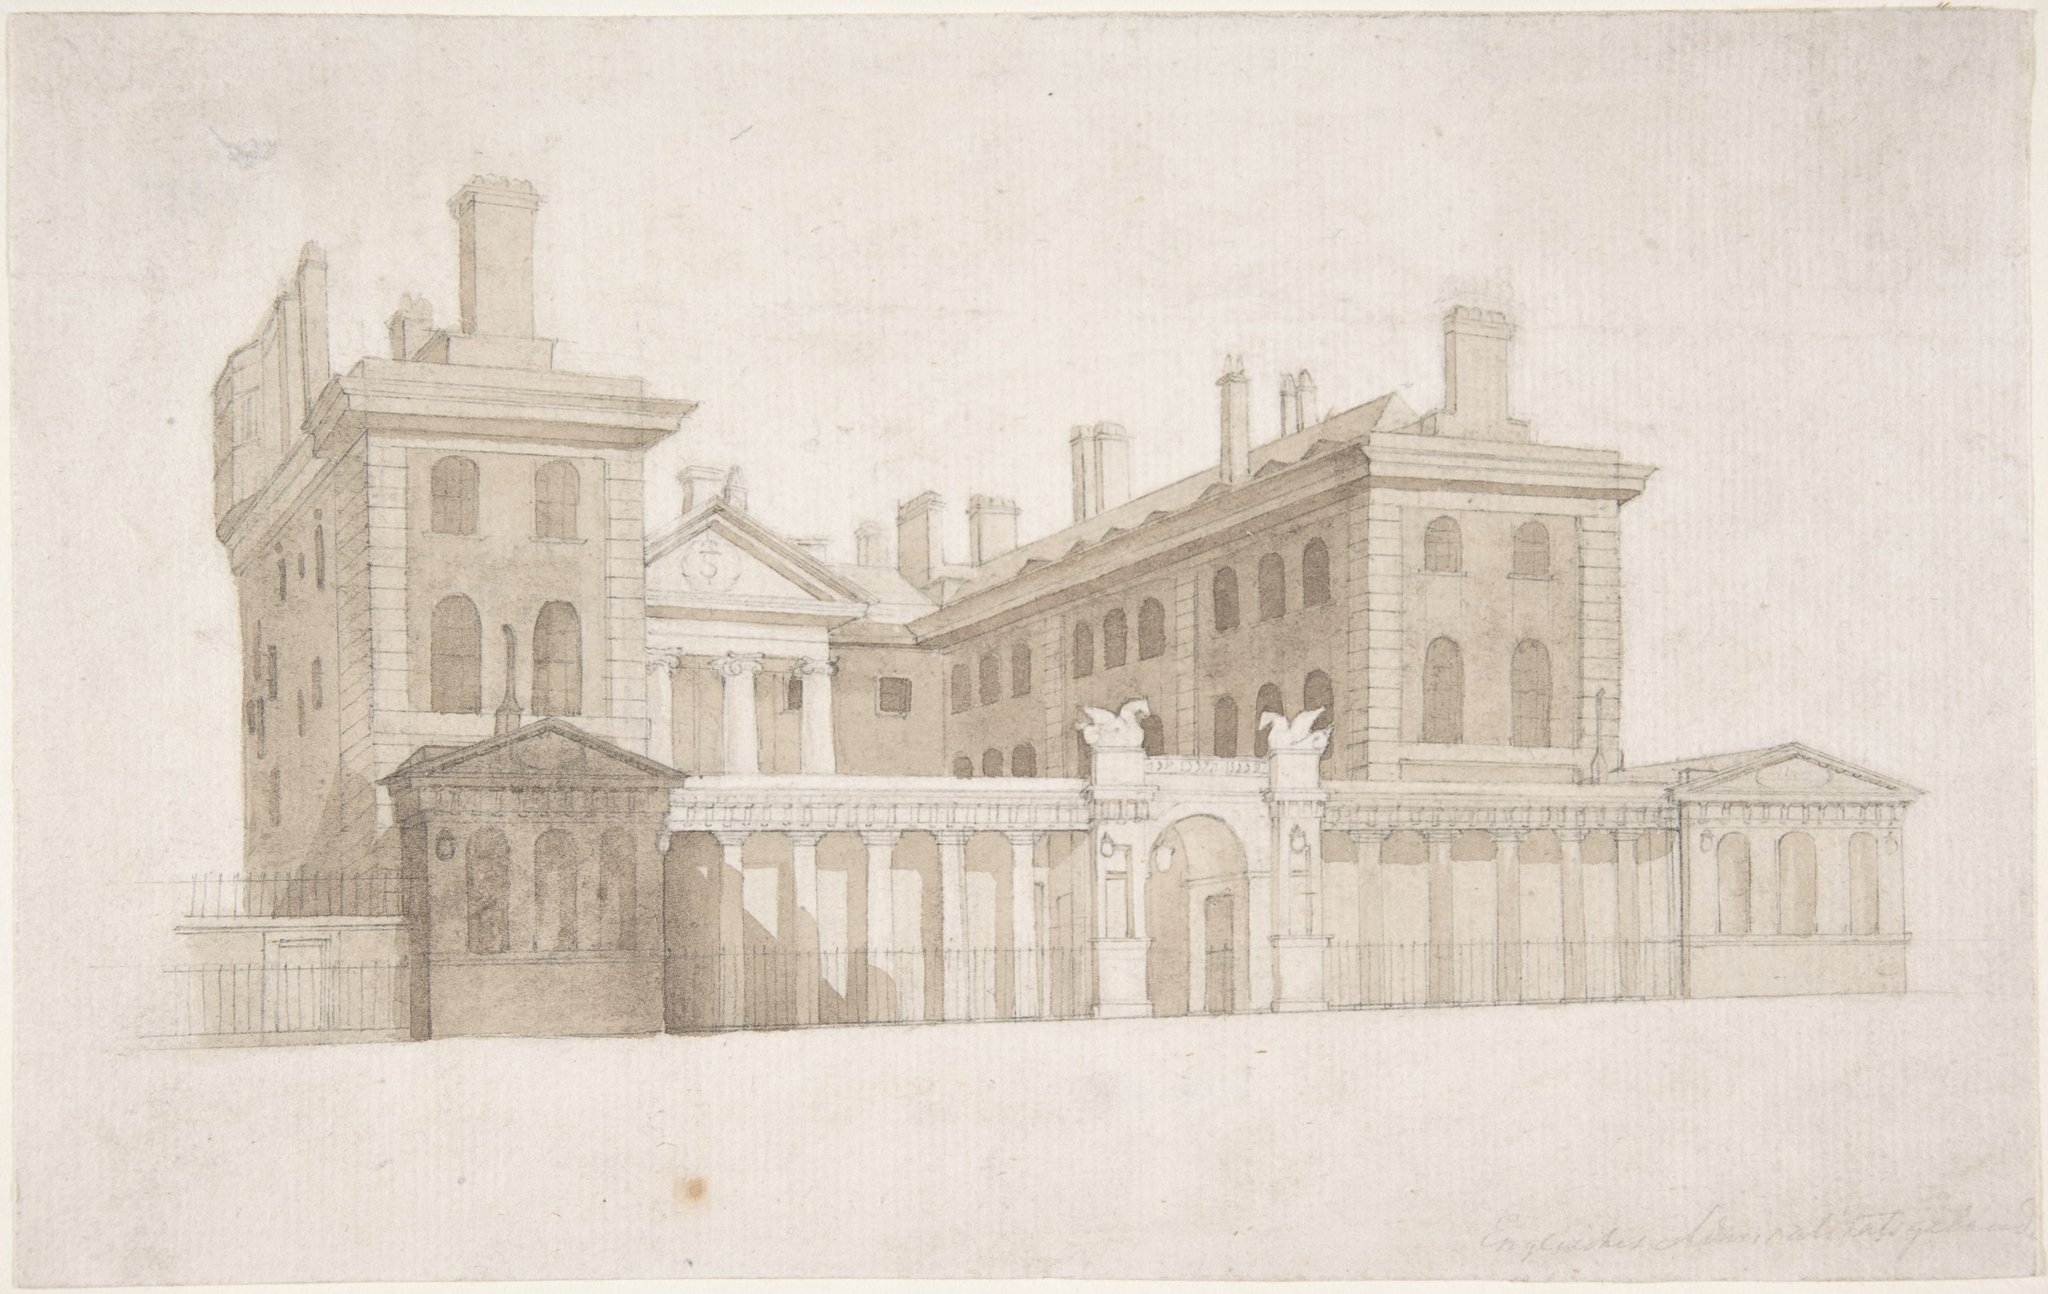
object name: drawing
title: The Old Admiralty in London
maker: carl gustav carus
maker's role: artist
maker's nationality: german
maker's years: 1789-1869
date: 1844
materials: graphite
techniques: wash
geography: germany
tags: architecture,buildings,london